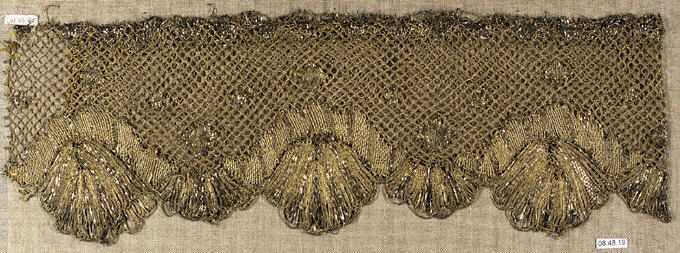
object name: piece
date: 1701-1800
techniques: lace